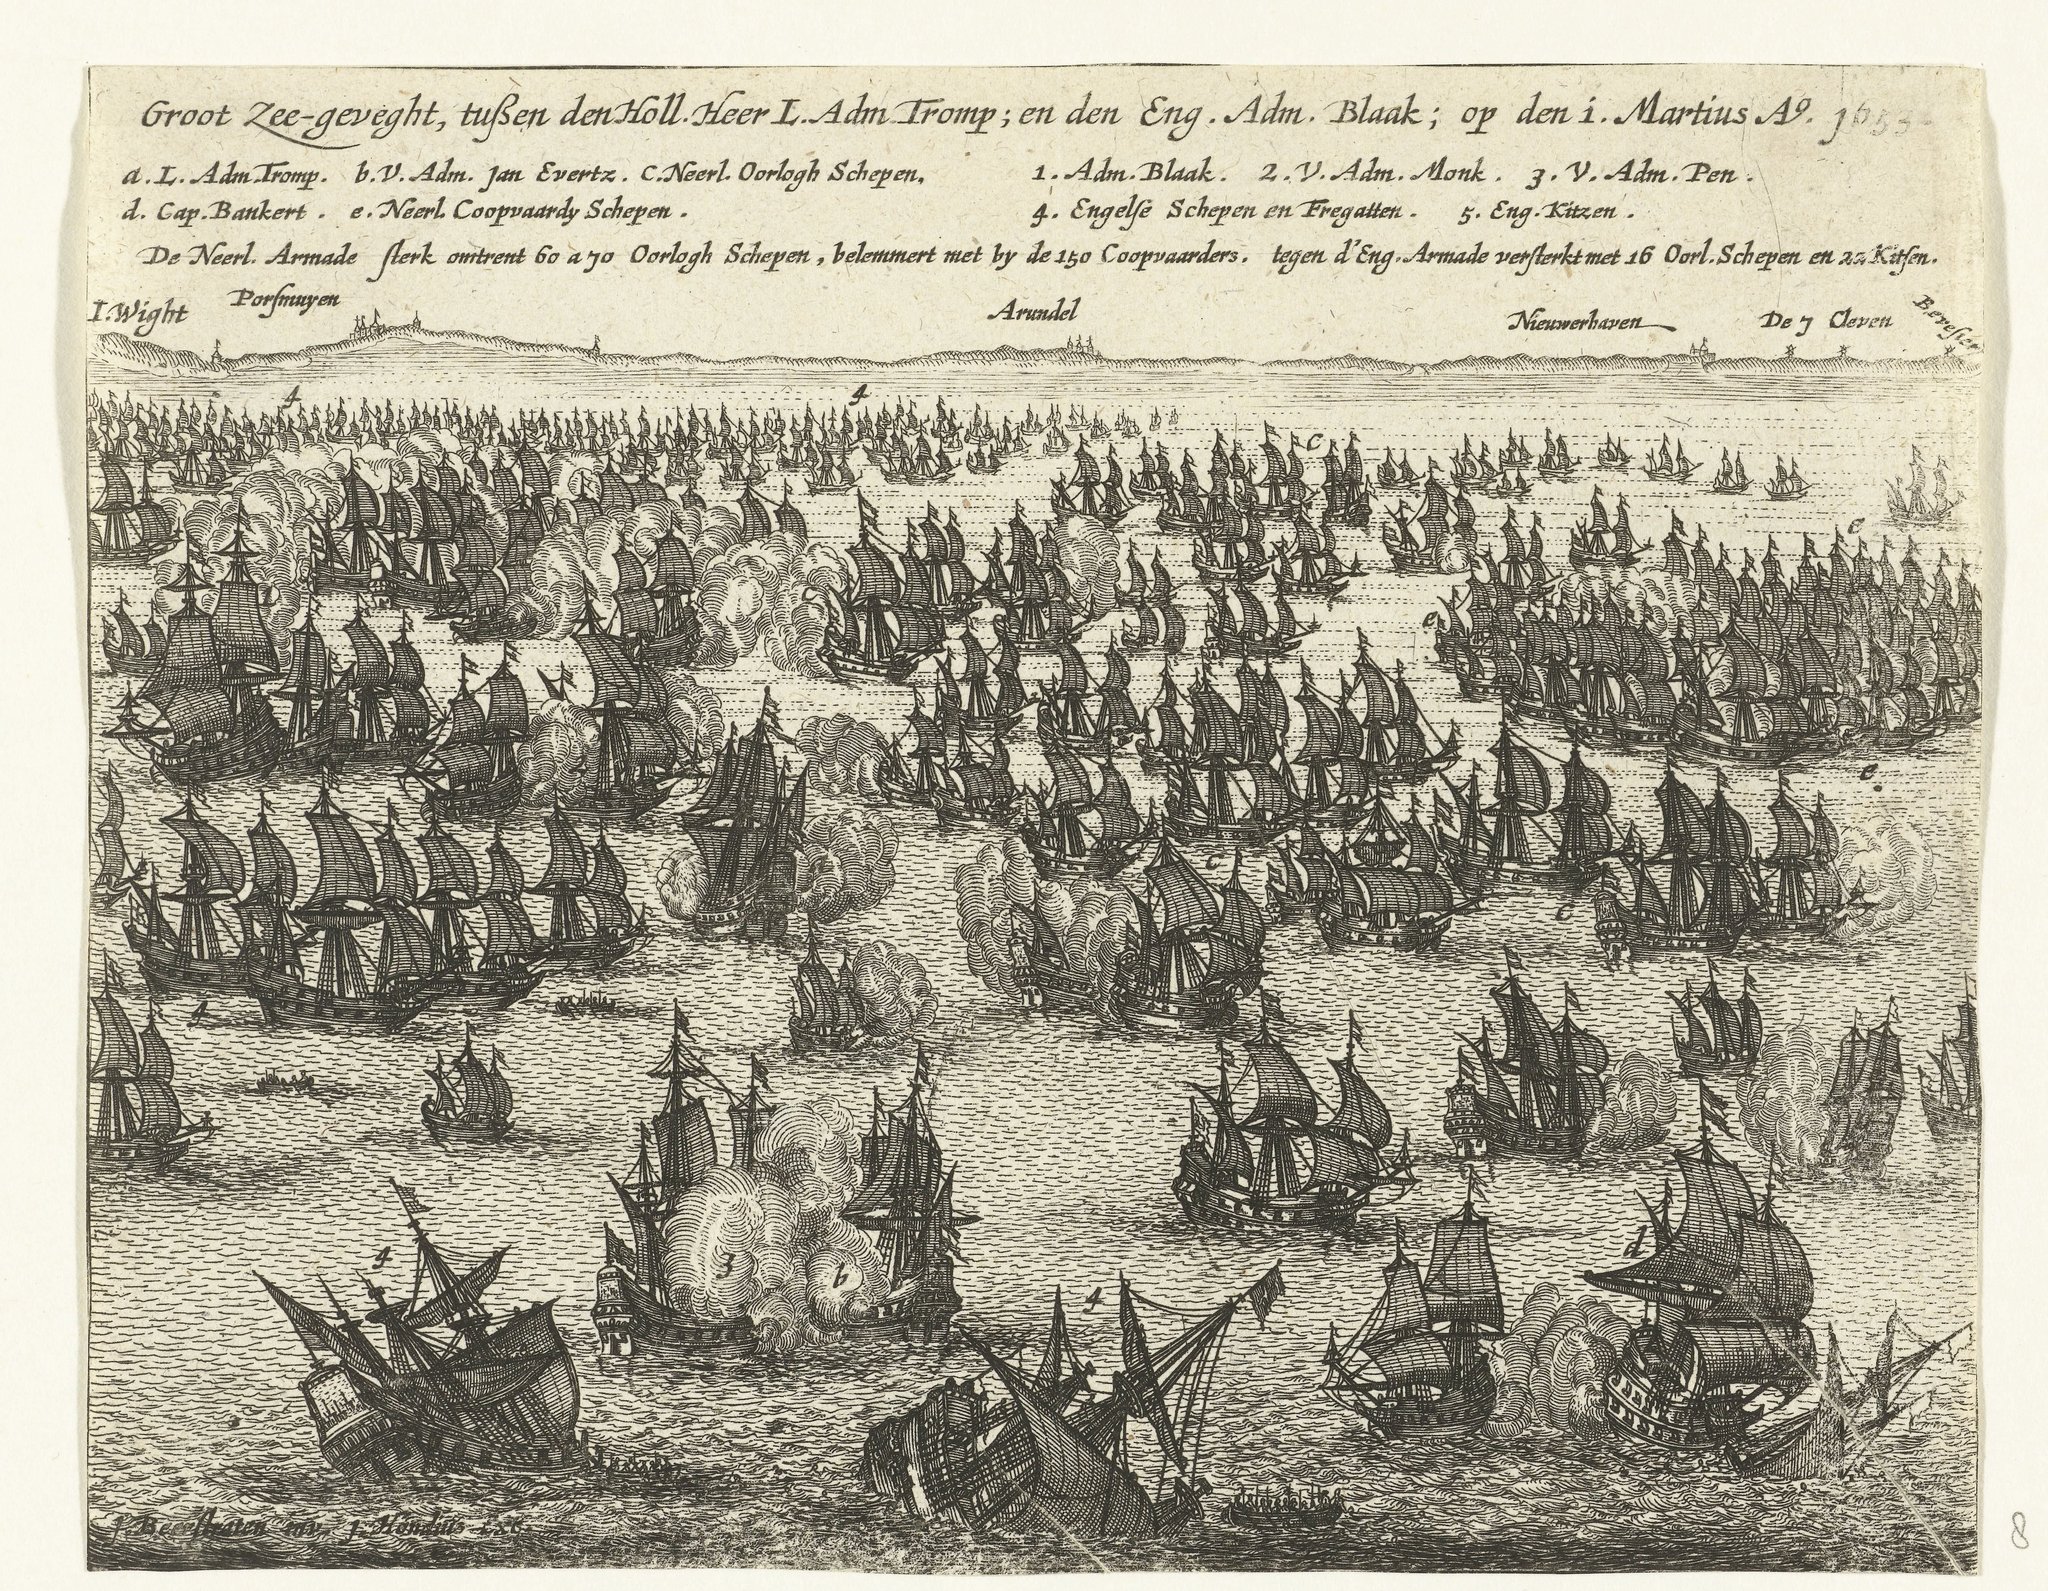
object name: print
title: Groot Zee-geveght; tussen den Holl. Heer L. Adm. Tromp; en den Eng. Adm. Blaak; op den 1 Martius Ao. 1653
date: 1654-1656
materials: paper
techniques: etching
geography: northern netherlands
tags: brielle, maarten harpertszoon tromp, battle (+ naval force), battle of portland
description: Driedaagse Zeeslag voor de Engelse zuidkust in de Eerste Engelse Oorlog tussen de Staatse vloot onder Maarten Tromp en de Engelse vloot onder Robert Blake, 1 maart 1653. Bovenaan de legenda a-e en 1-5. Ongenummerd [8].